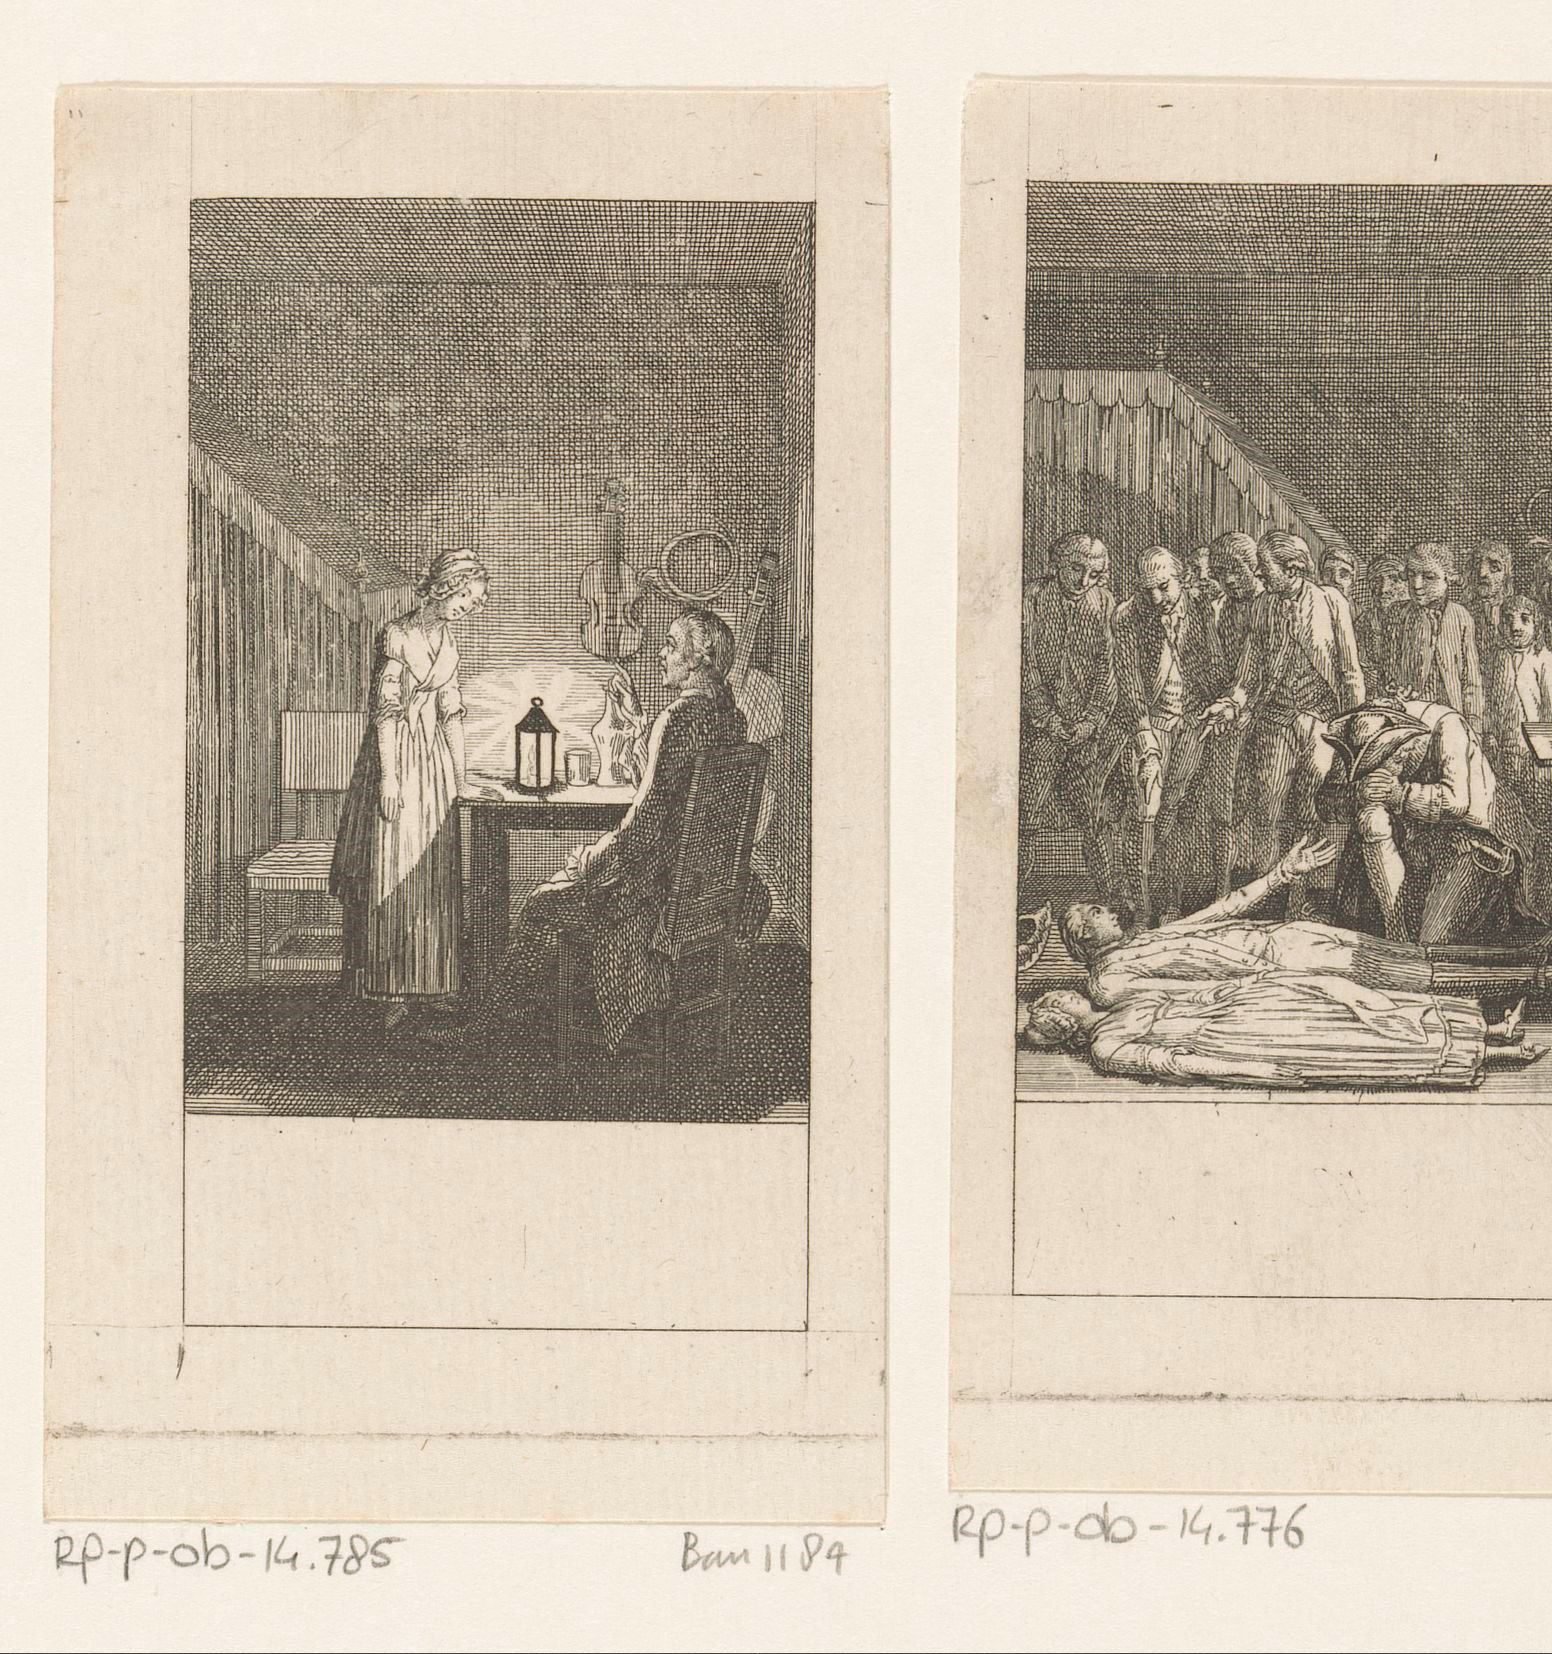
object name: print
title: Luise laat haar vader de brief aan Ferdinand lezen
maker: daniel nikolaus chodowiecki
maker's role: draughtsman, print maker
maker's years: 1726-1801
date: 1785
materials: paper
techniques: etching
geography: berlin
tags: literature, lantern, letter, envelope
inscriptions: collector's mark: Lugt 2228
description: Vervaardigd voor Friedrich von Schiller 'Kabale und Liebe'. Latere staat gebruikt voor: Königl. Grossbrit. Genealogischer Kalender auf das Jahr 1786. Lauenburg: J. G. Berenberg, 1785.